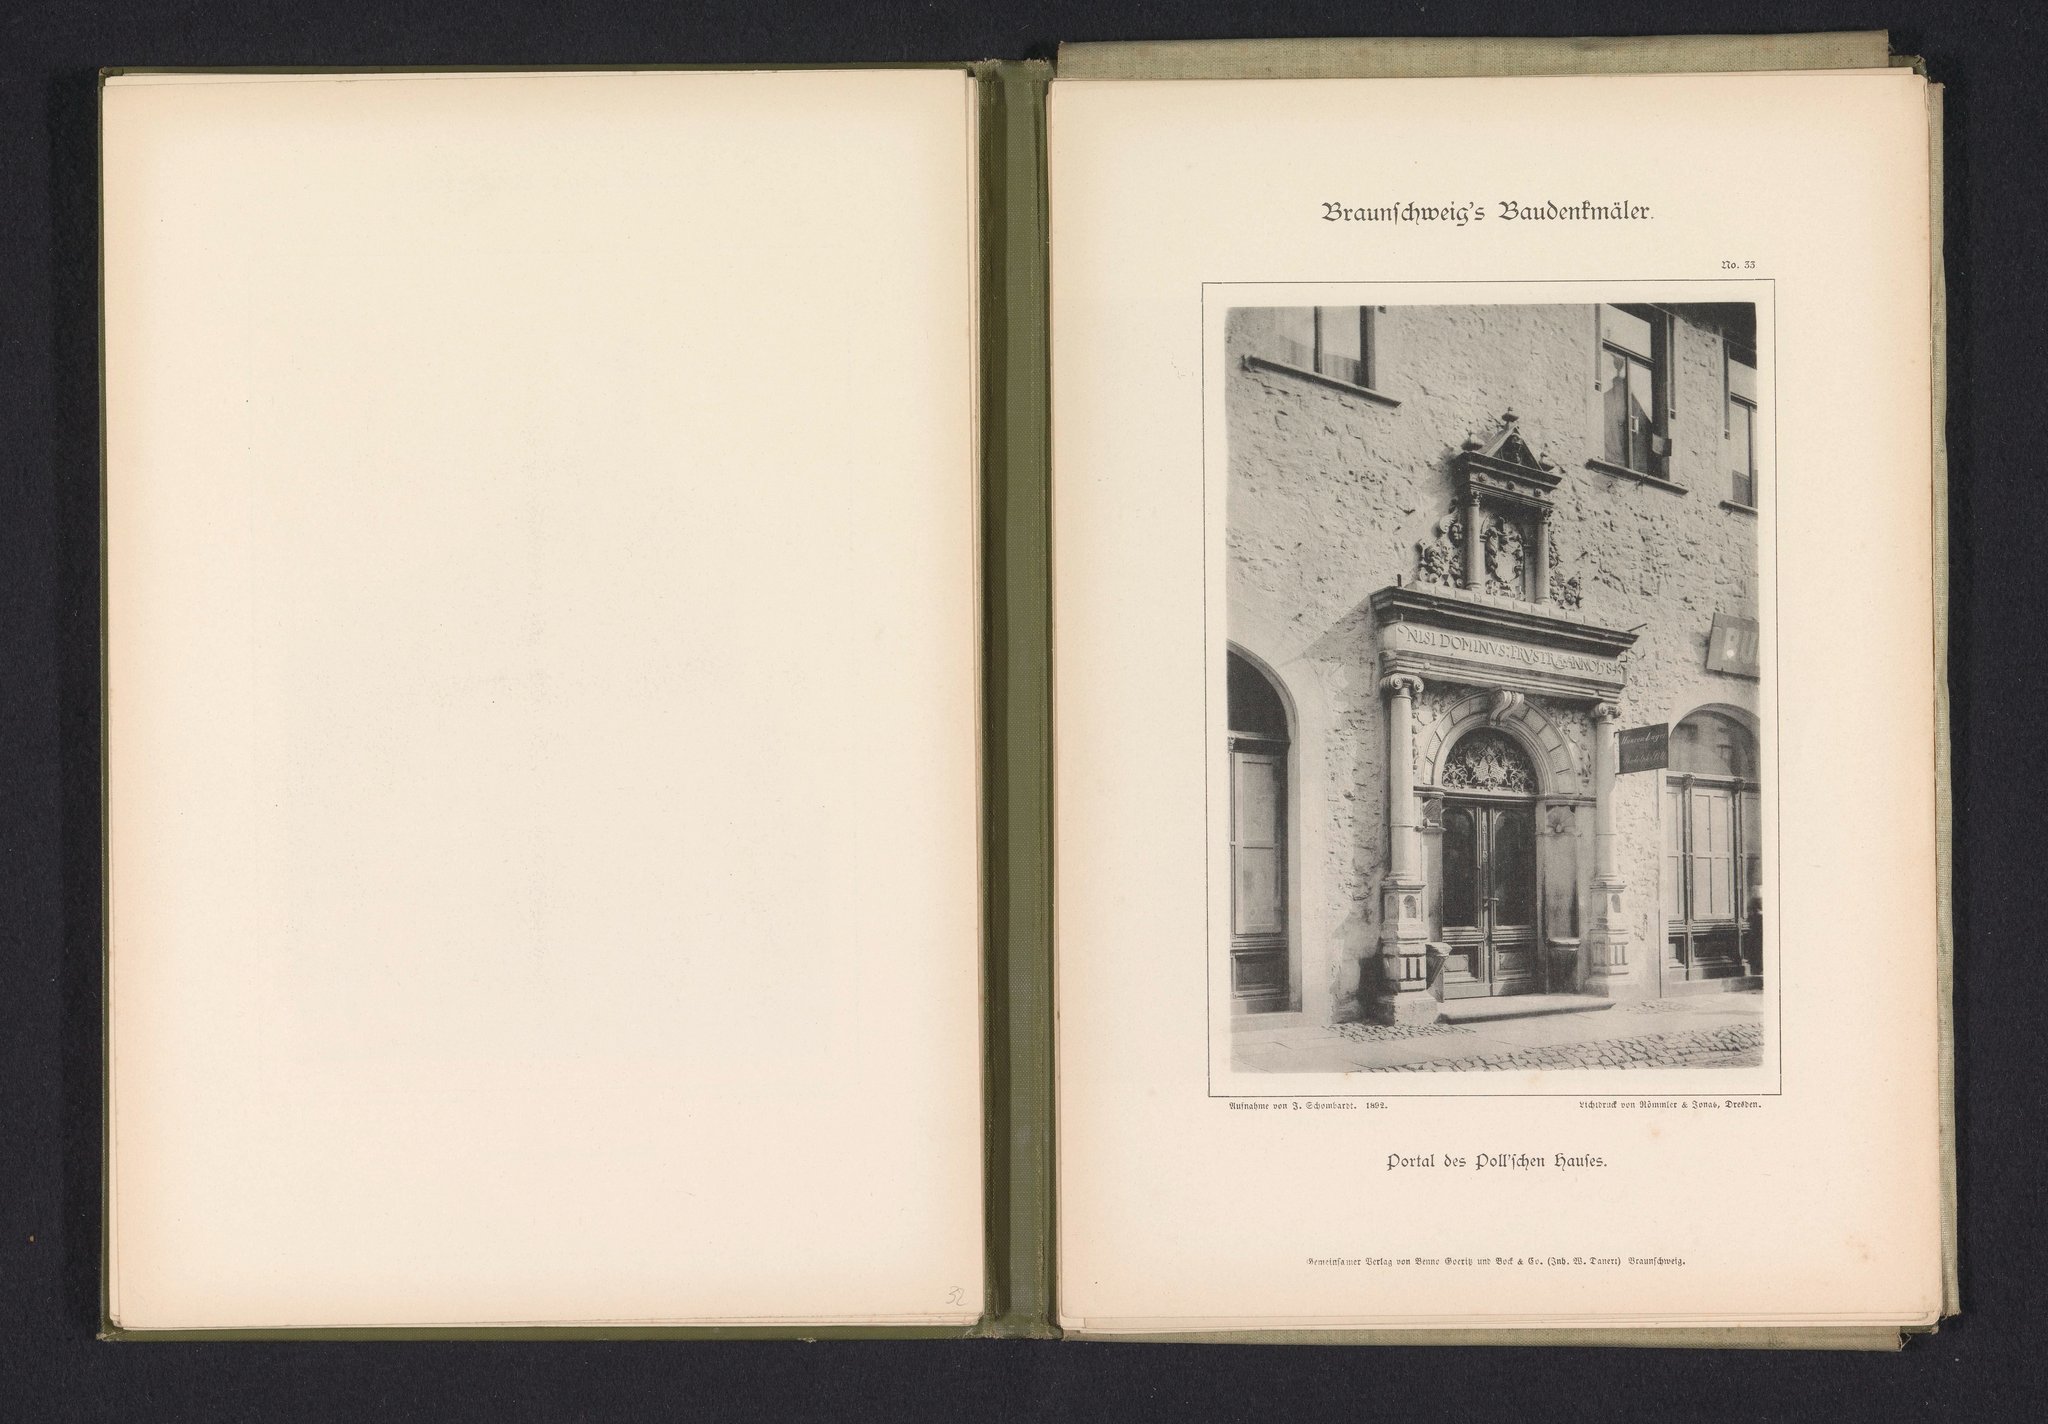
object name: photomechanical print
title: Braunschweig's Baudenkmäler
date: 1892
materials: paper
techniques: photograph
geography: braunschweig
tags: gate, entrance, façade (of house or building)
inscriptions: number: ‘No. 33.’